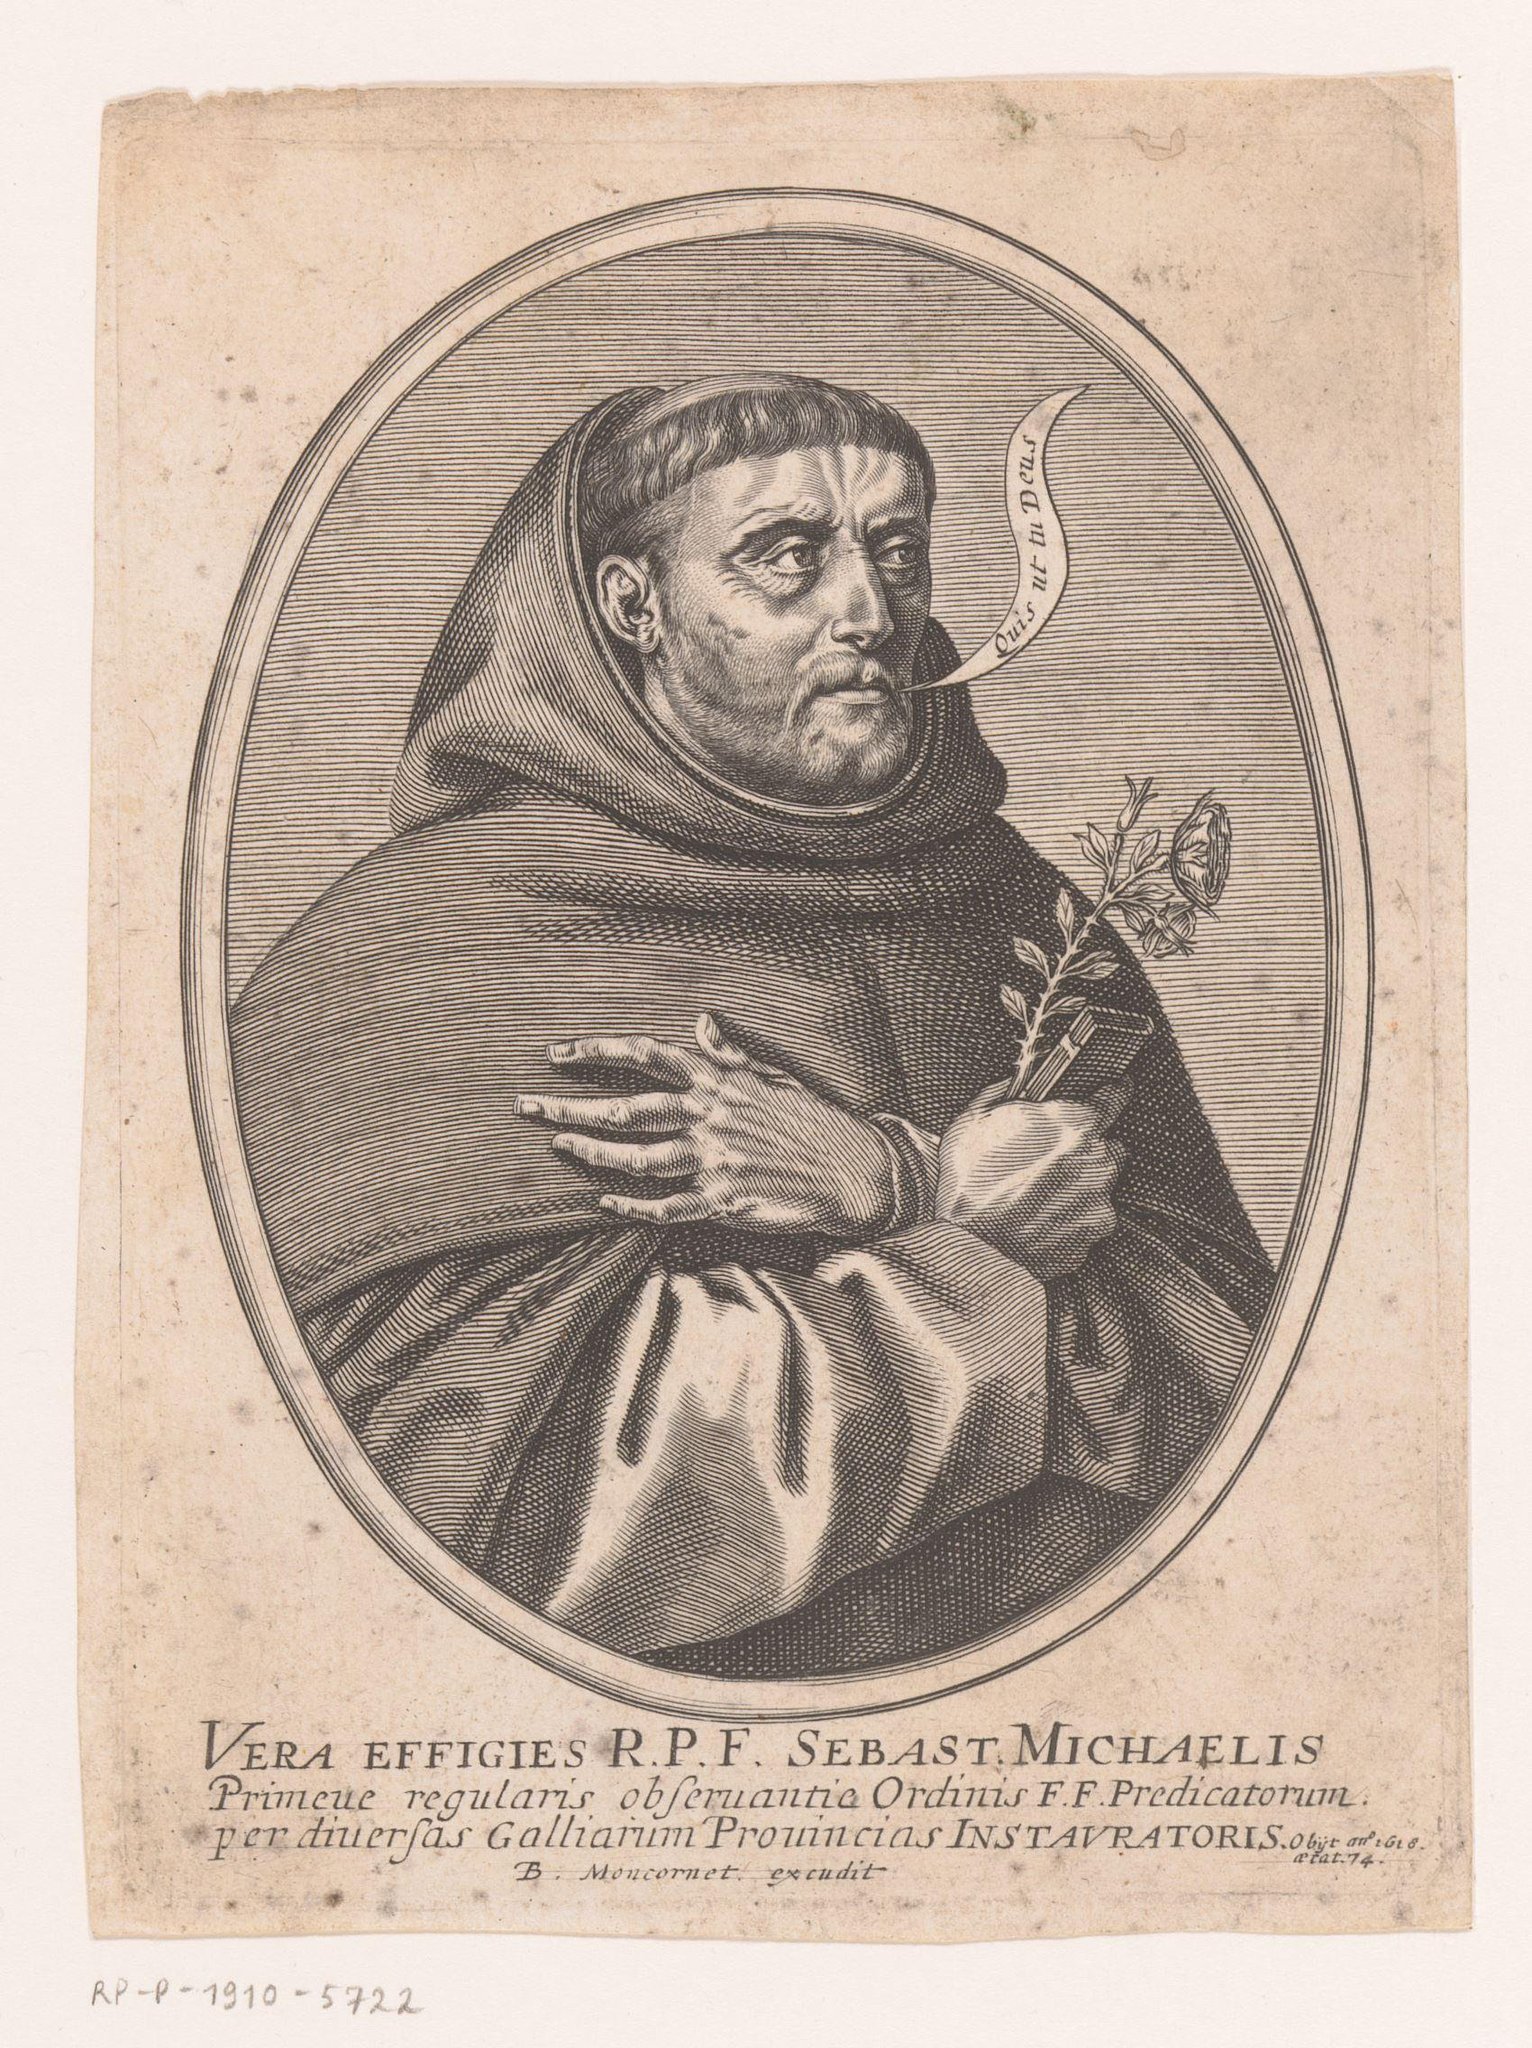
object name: print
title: Portret van Sébastien Michaëlis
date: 1618-1668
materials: paper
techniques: engraving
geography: france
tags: historical persons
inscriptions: collector's mark: Lugt 2228